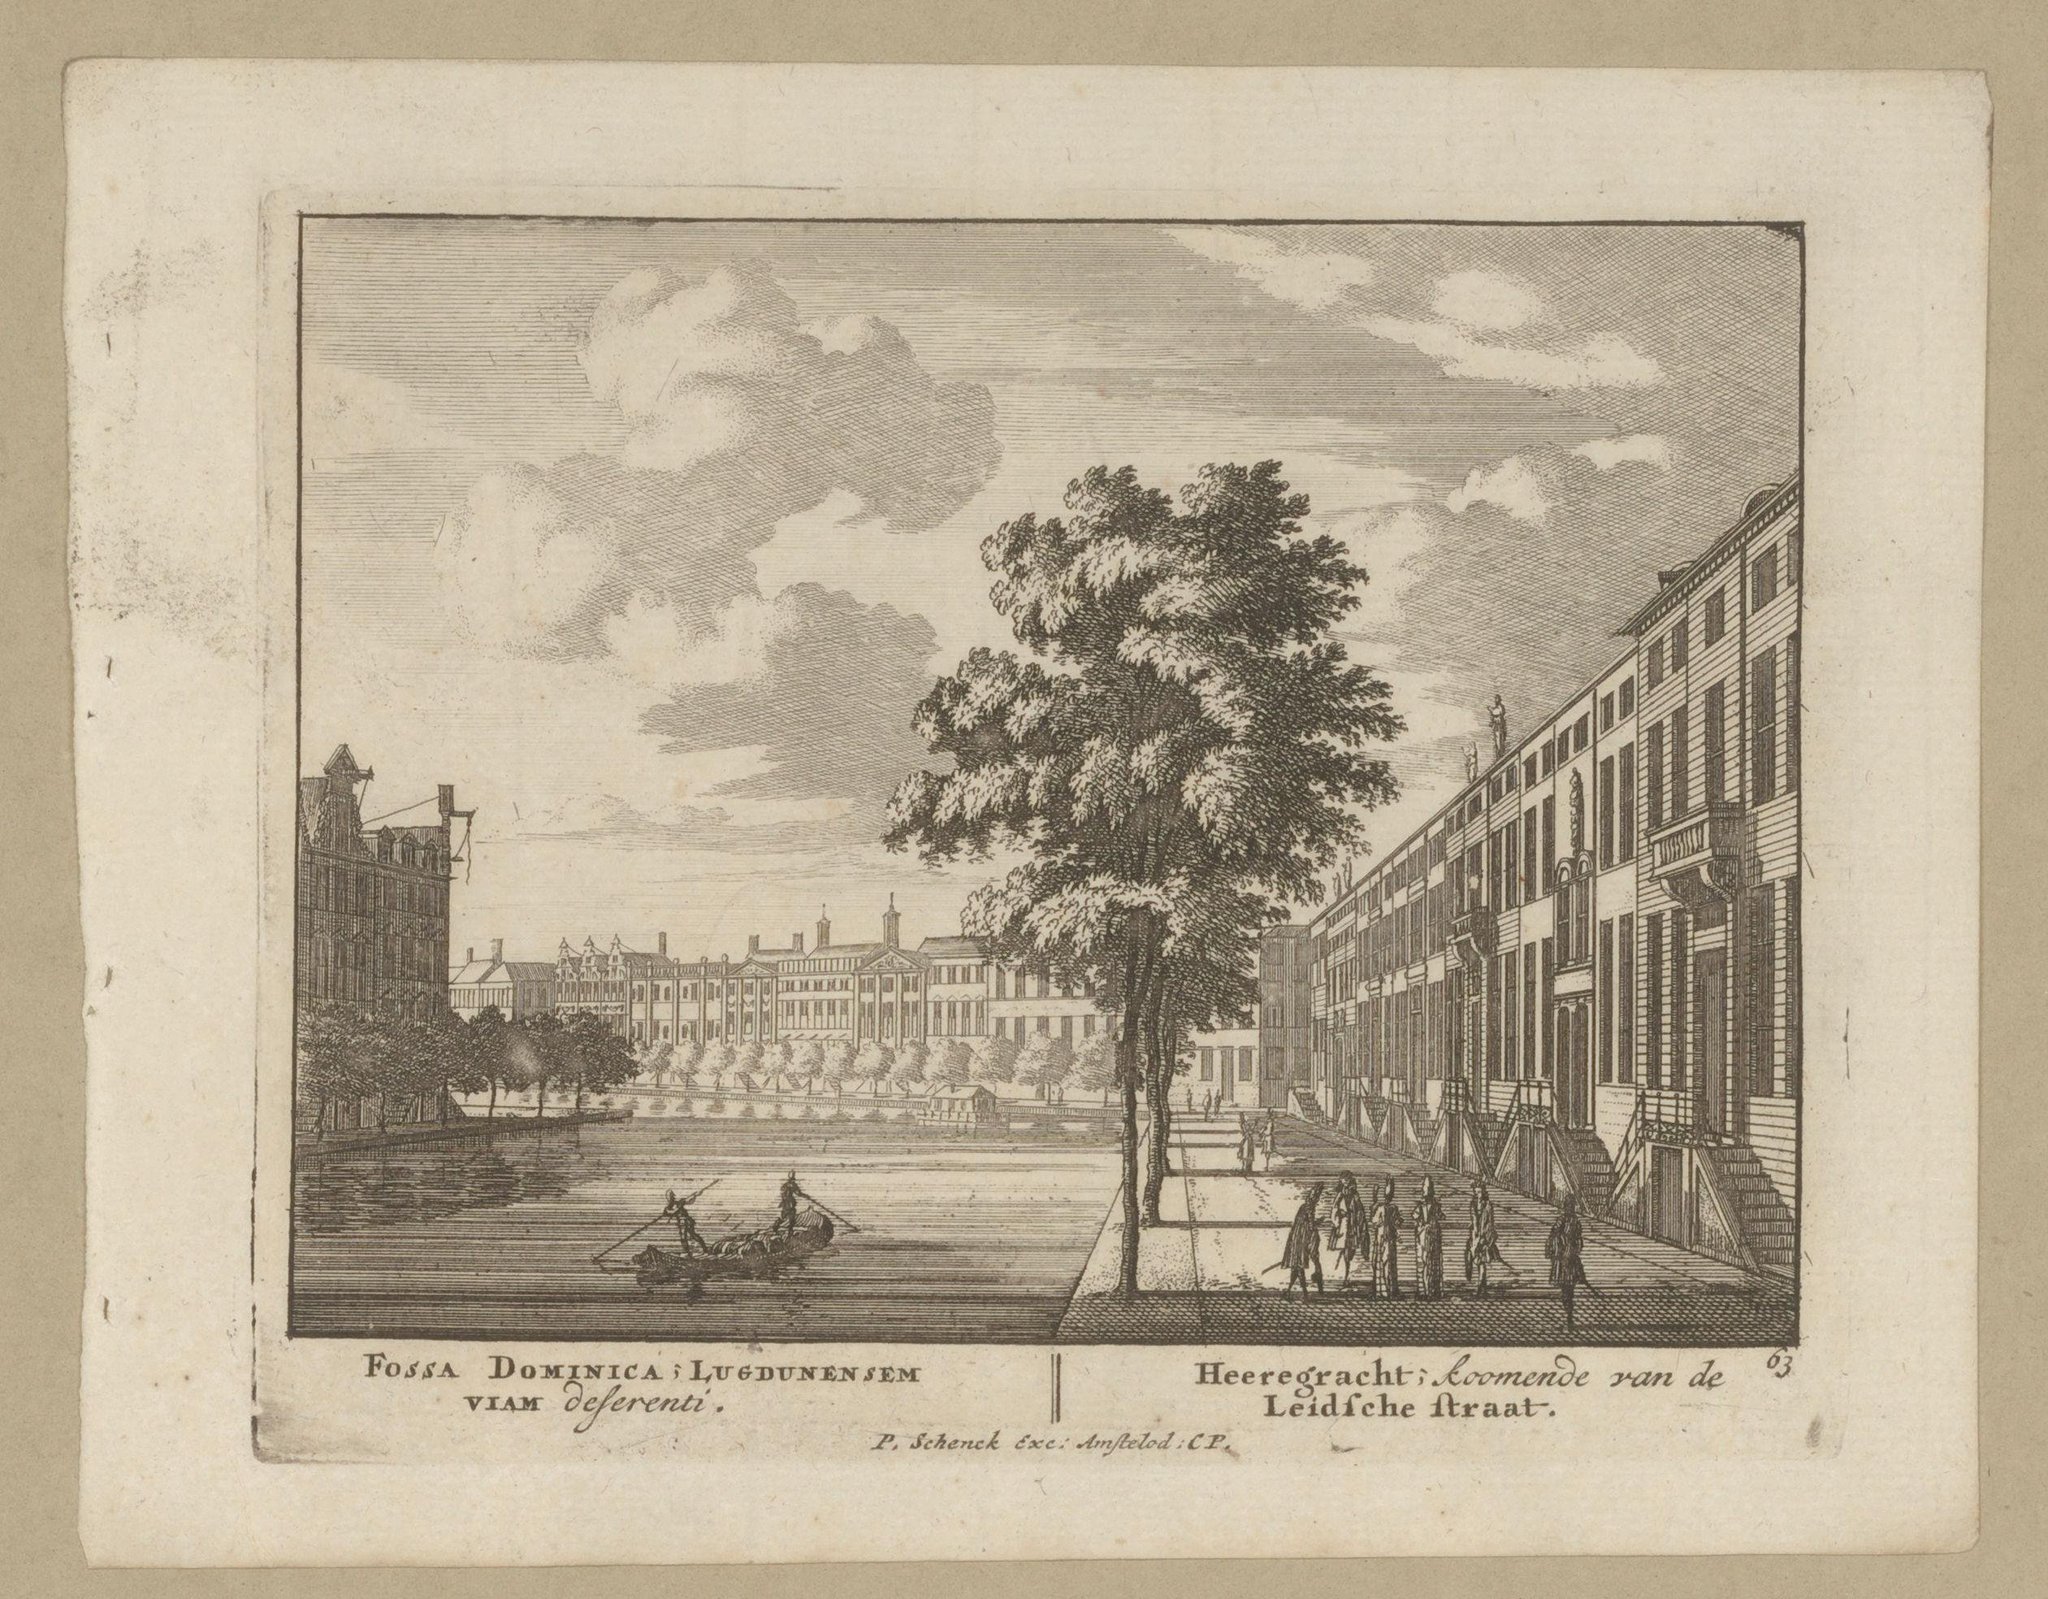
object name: print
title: Heerengracht; koomende van de Leidsche straat / Fossa Dominica; Lugdunensem viam deserenti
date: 1694-1697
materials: paper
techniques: etching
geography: amsterdam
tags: city-view in general; 'veduta', canal, street, boat propelled by man or animal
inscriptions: collector's mark: ‘8,98’ Lugt 1641b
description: Prent ook gebruikt in: Admirandorum Quadruplex Spectaculum. Amsterdam: Pieter Schenk (I), s.a. [1694-1697].* * De titelprent, opdracht en het portret van Frederik van Saksen zijn gegraveerd door Pieter Schenk (I). De overige prenten uit deze serie zijn, zoals aangegeven op de titelprent, van de hand van Jan van Call (I).